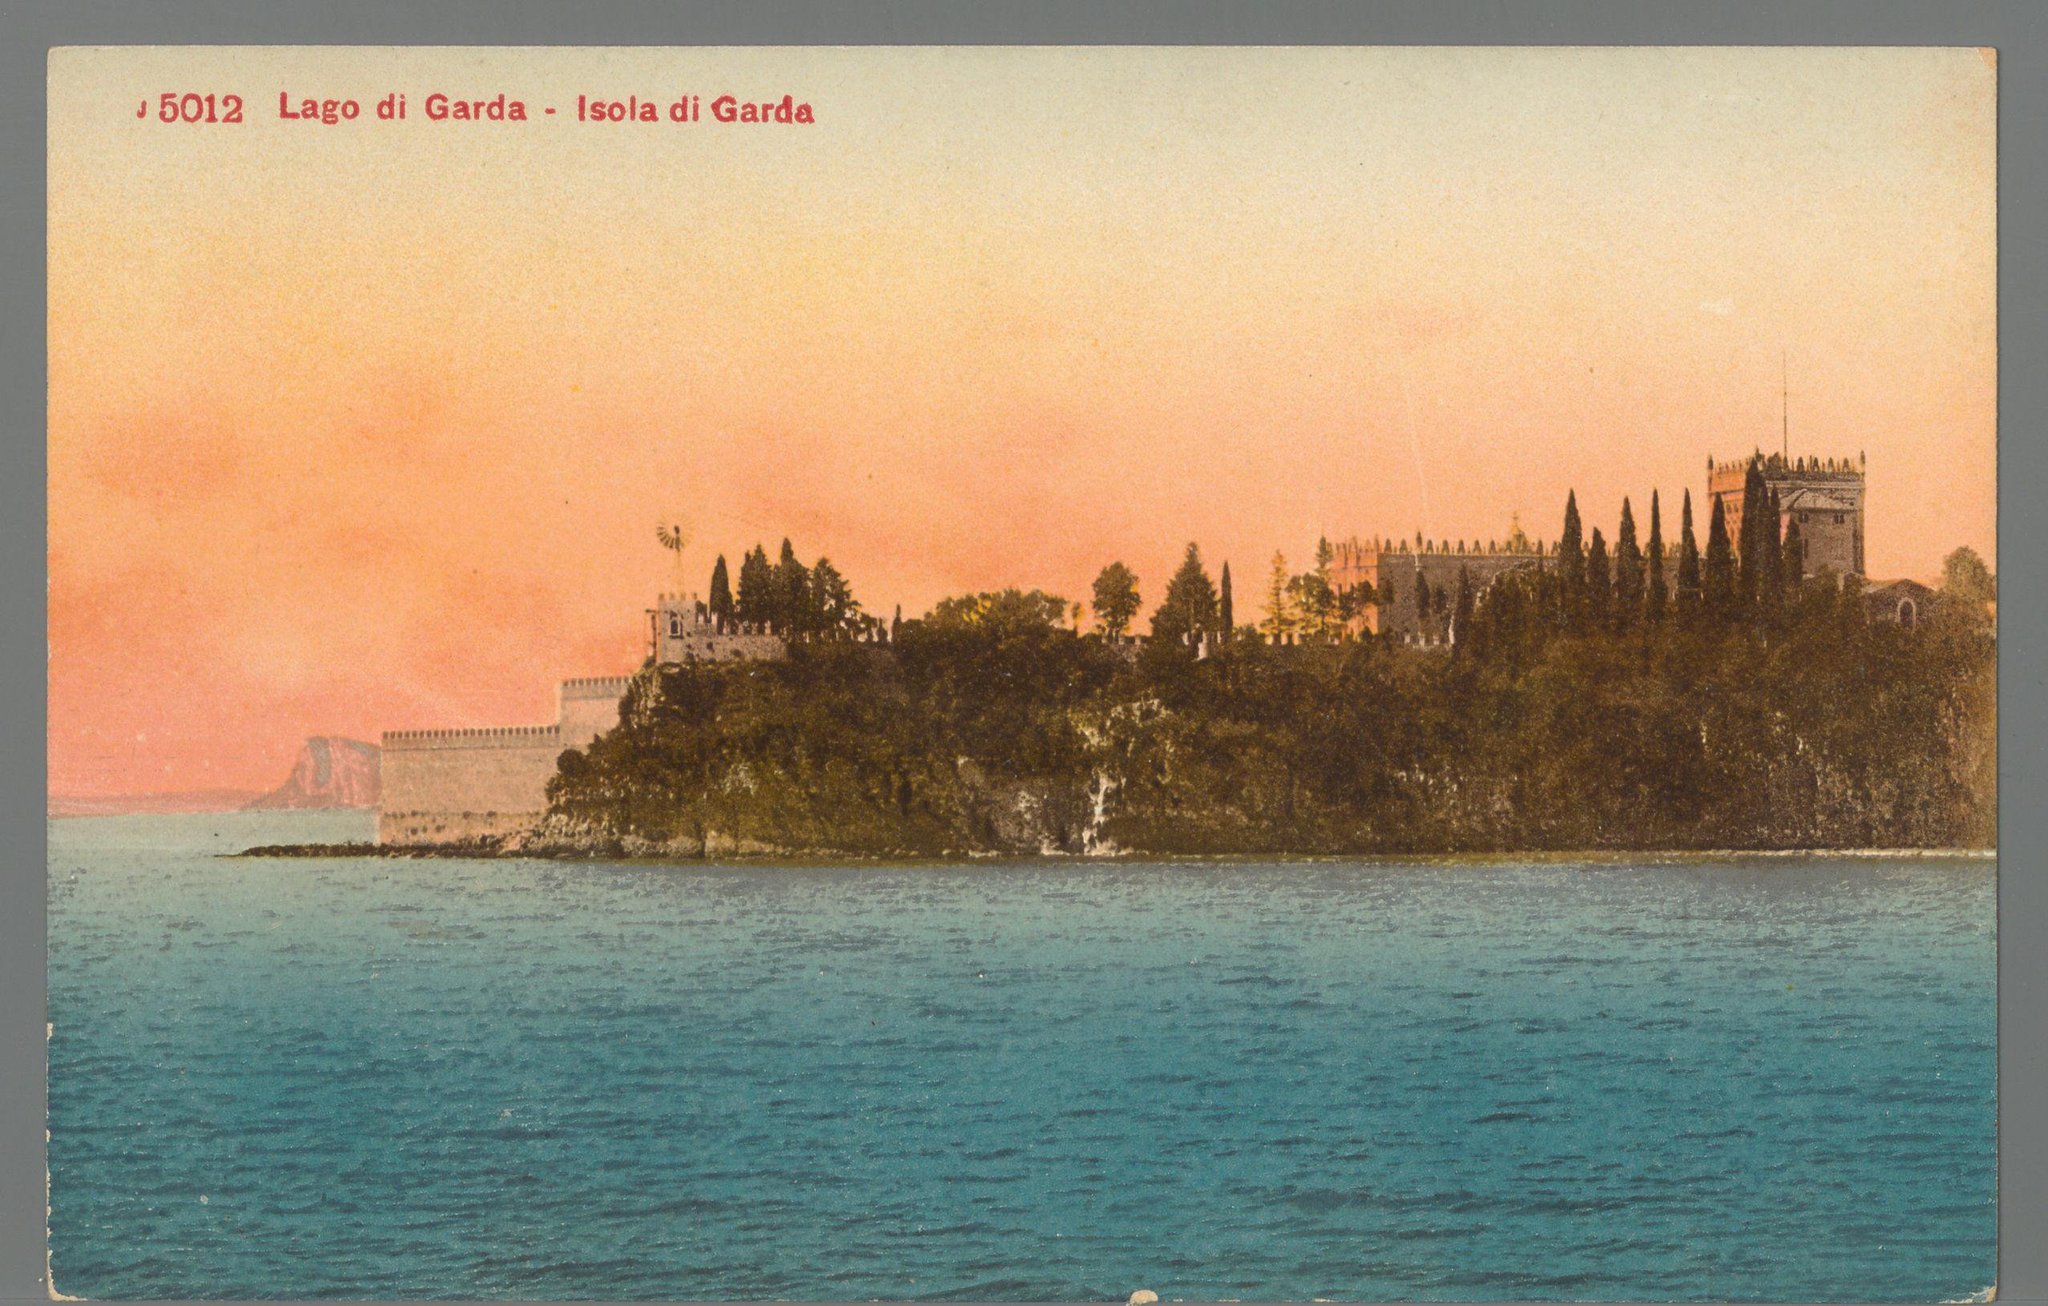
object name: ansichtkaart, prentbriefkaart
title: Lago di Garda. Isola da Garda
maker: Anonymous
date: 1905-1930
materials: cardboard, photographic process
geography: isola del garda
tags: island, castle, lake